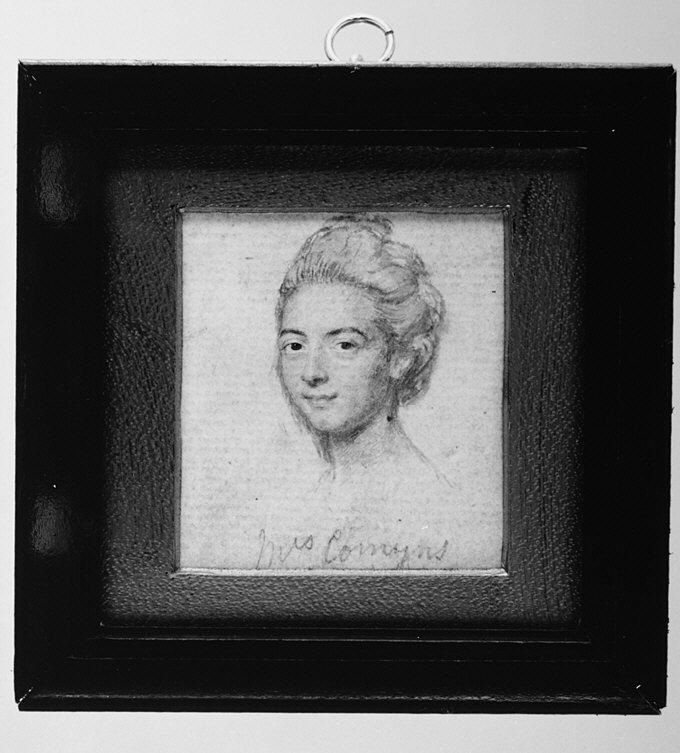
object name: painting, miniature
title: Mrs. Comyns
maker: john smart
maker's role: artist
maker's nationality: british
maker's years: 1741-1811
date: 1760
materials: paper, pencil, watercolor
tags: portraits,women